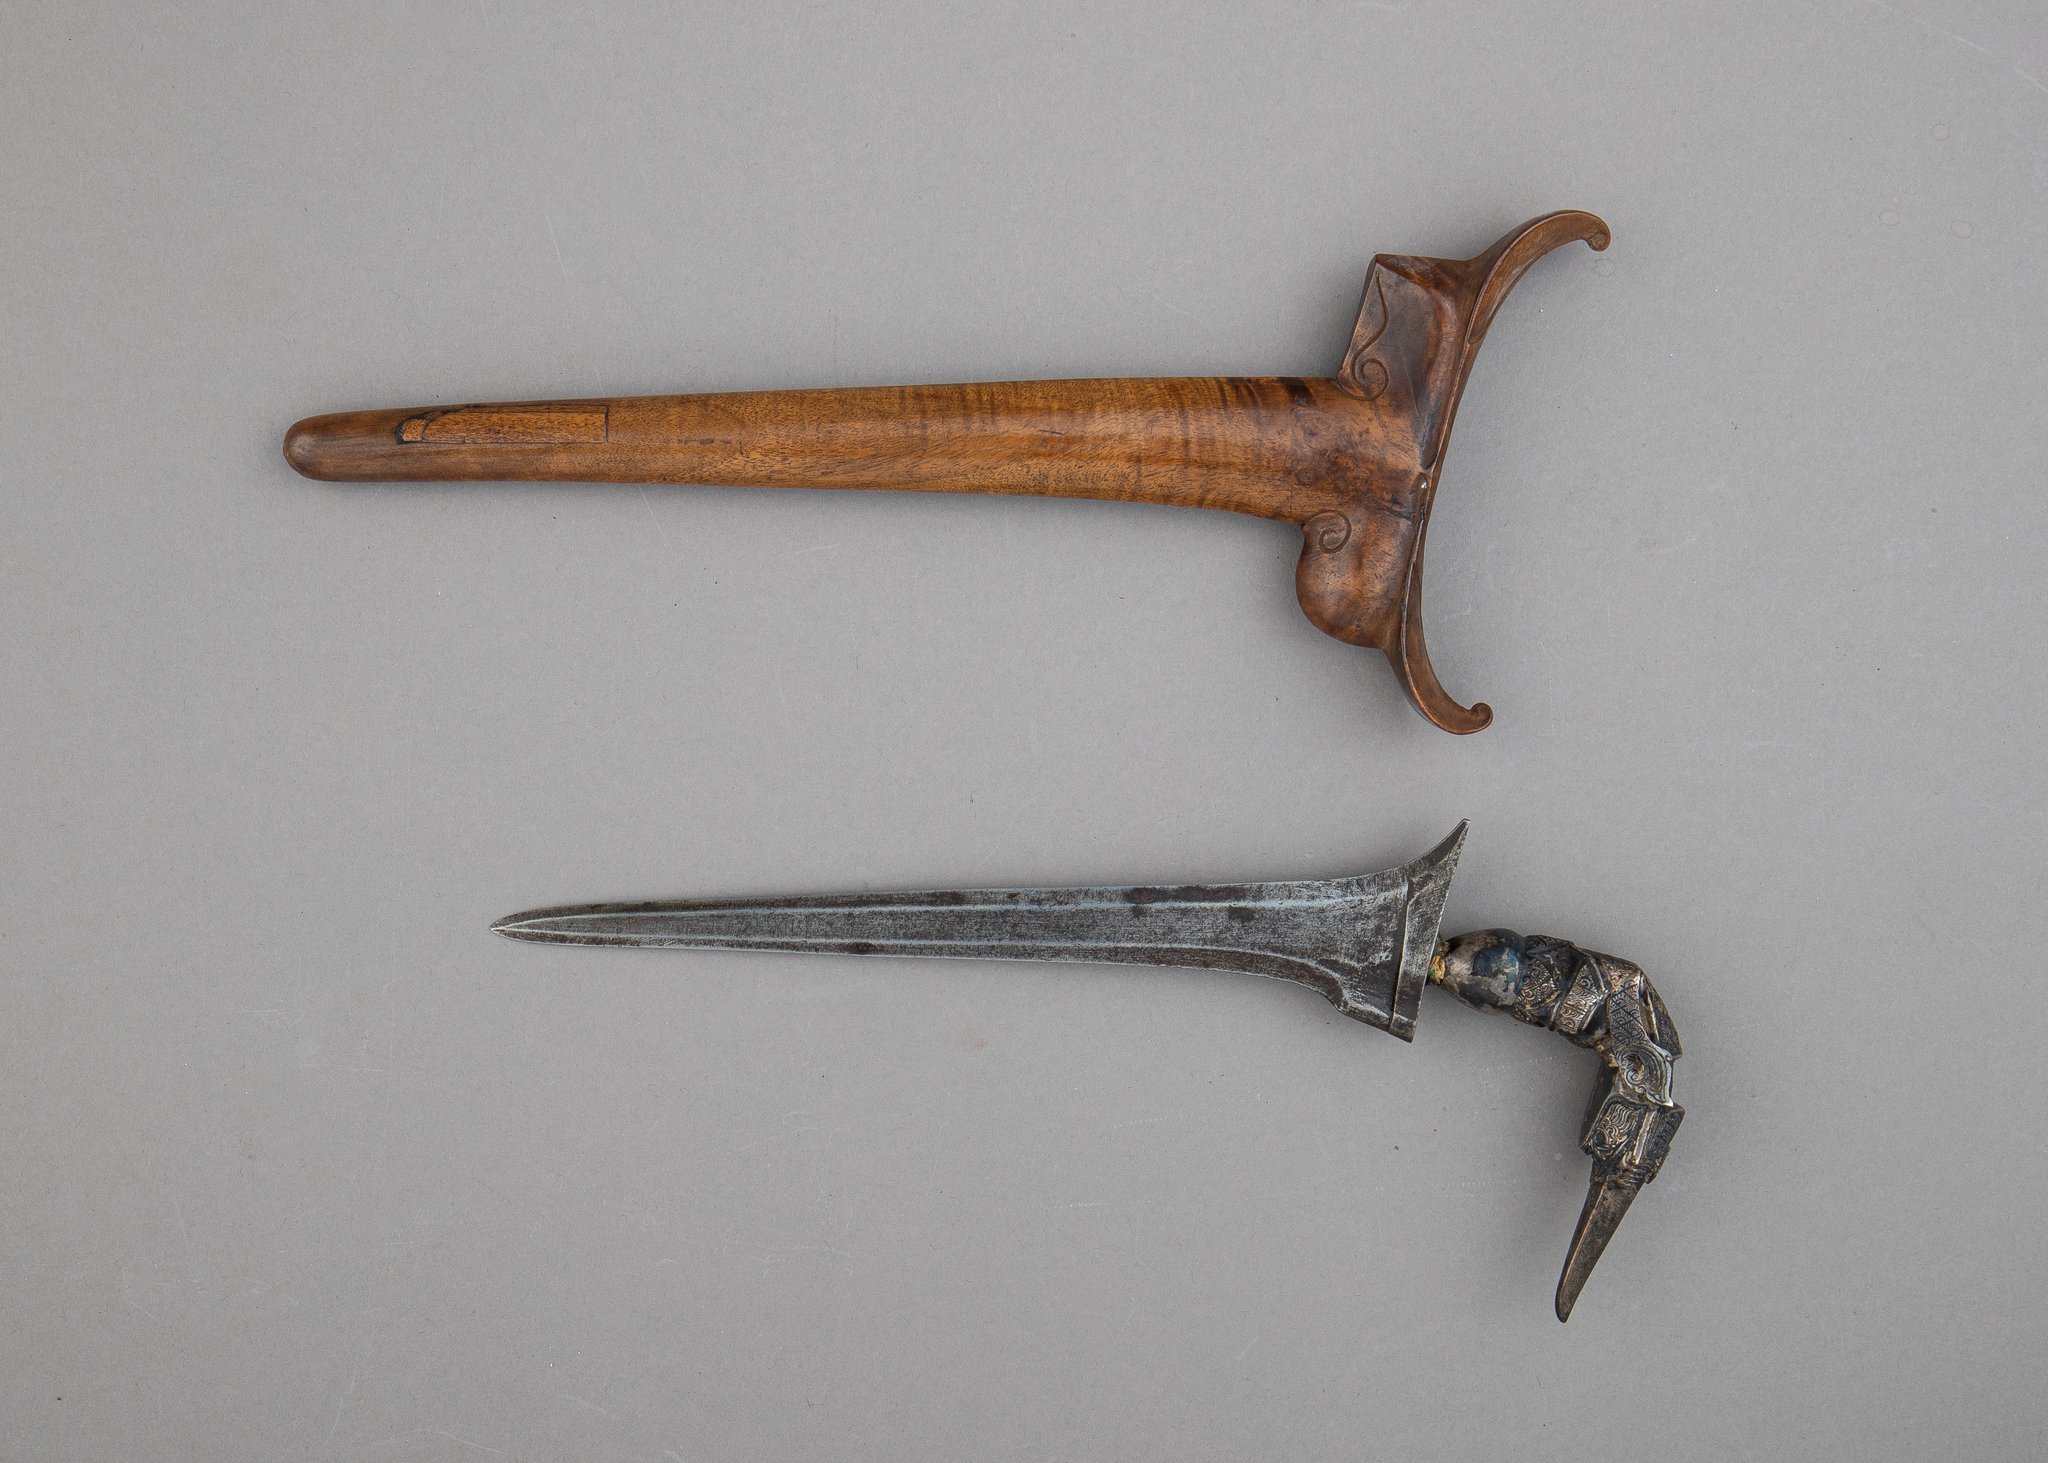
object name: kris with sheath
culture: sumatran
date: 1501-1900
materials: silver, steel, wood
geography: indonesia